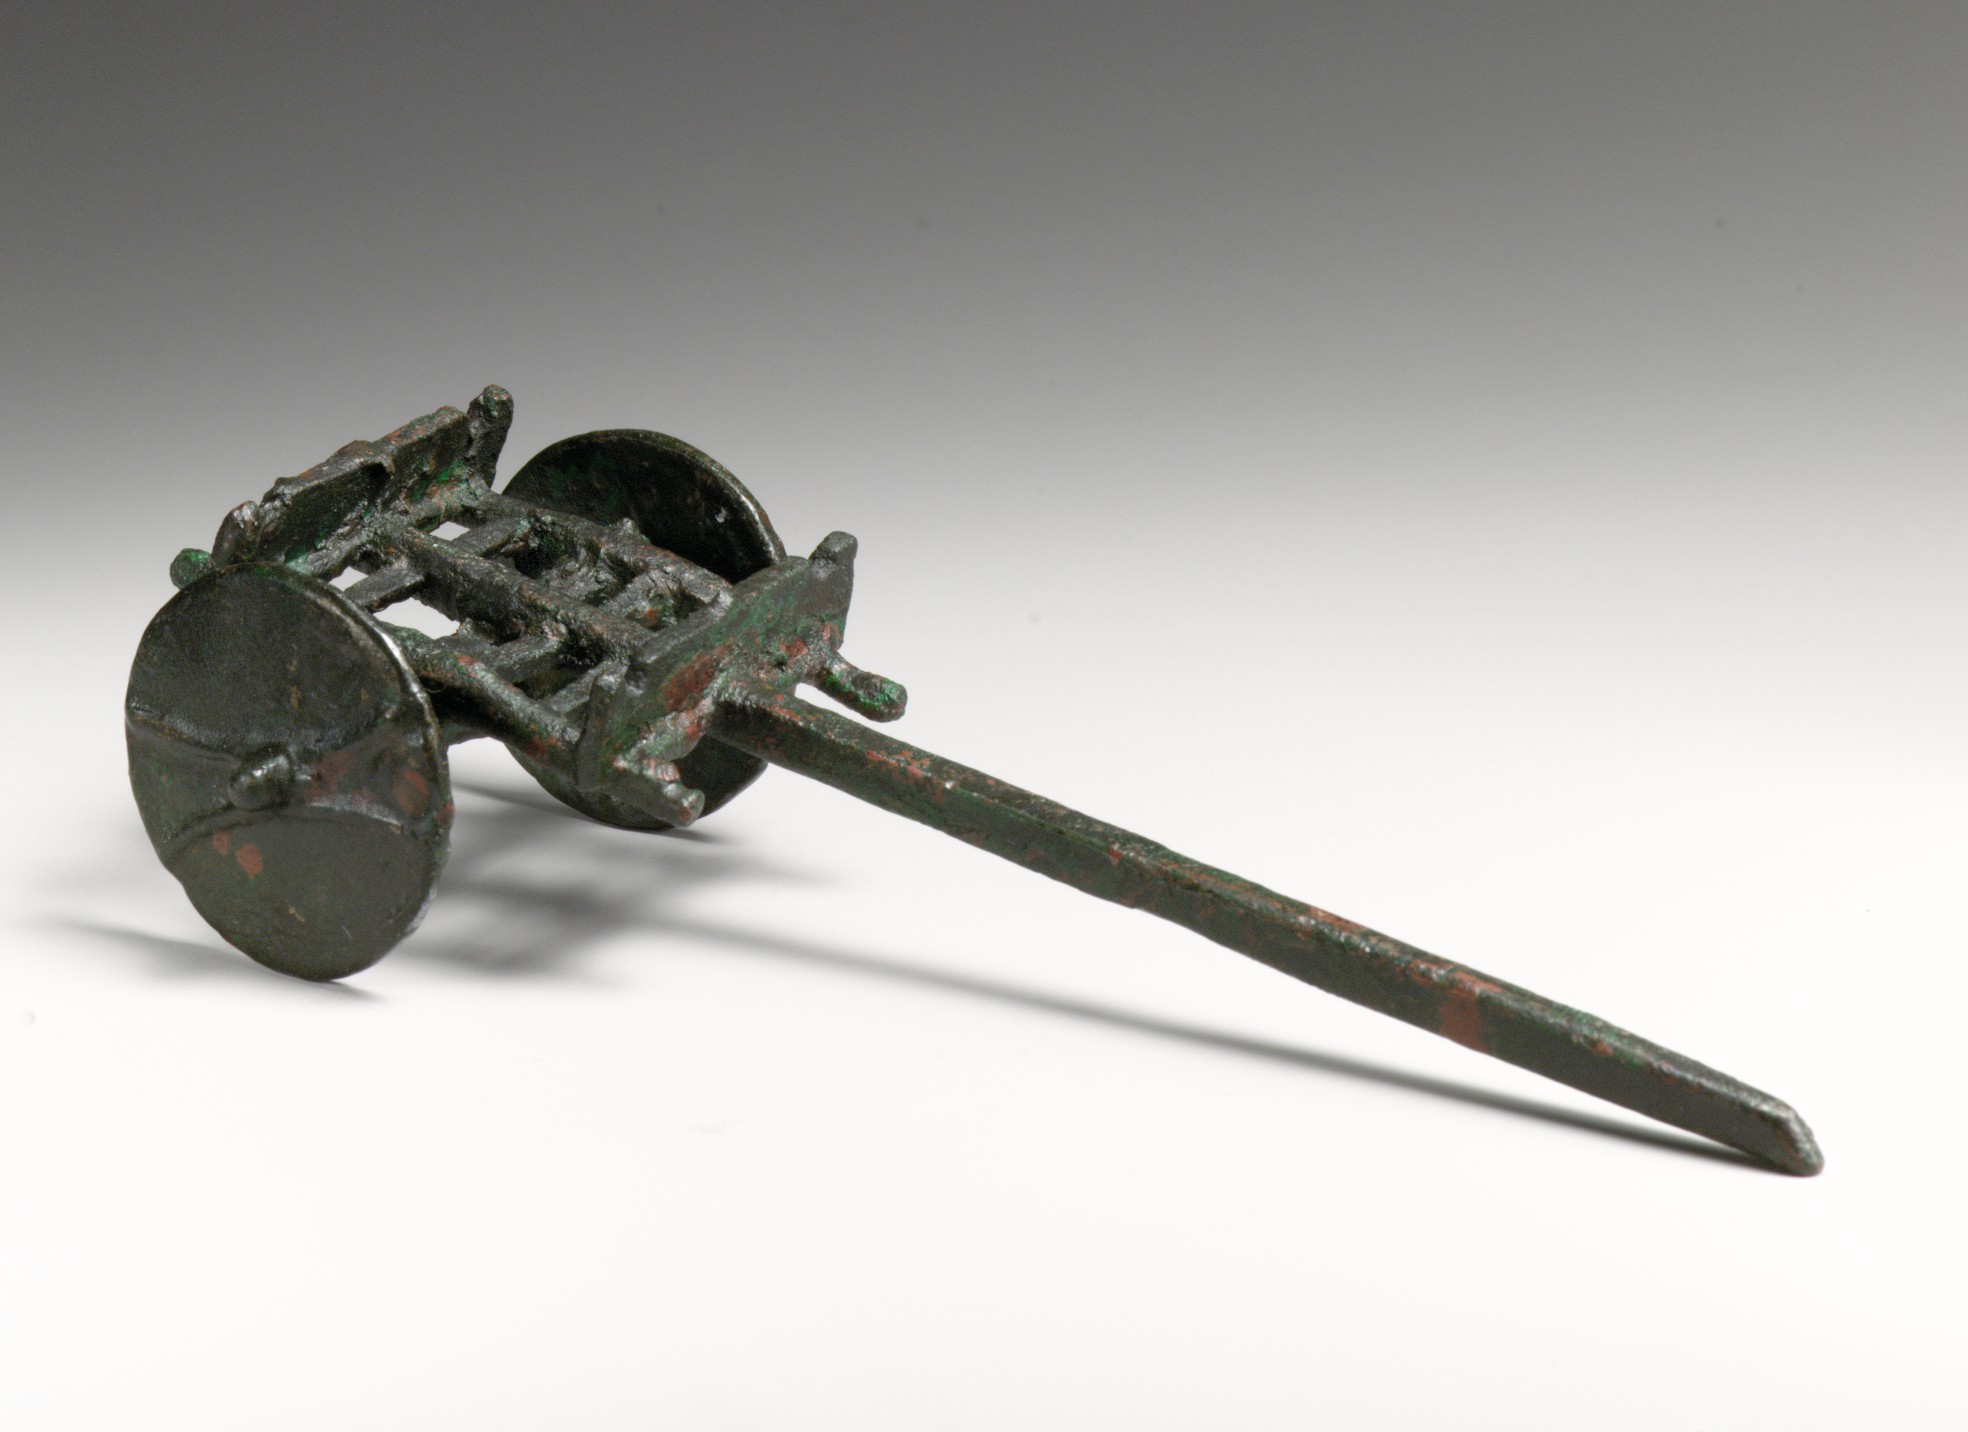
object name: model of a cart with farmyard group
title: Bronze model of a cart with farmyard group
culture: etruscan or roman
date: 200 BCE-100 CE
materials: bronze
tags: bulls,goats,pigs,rams,carts